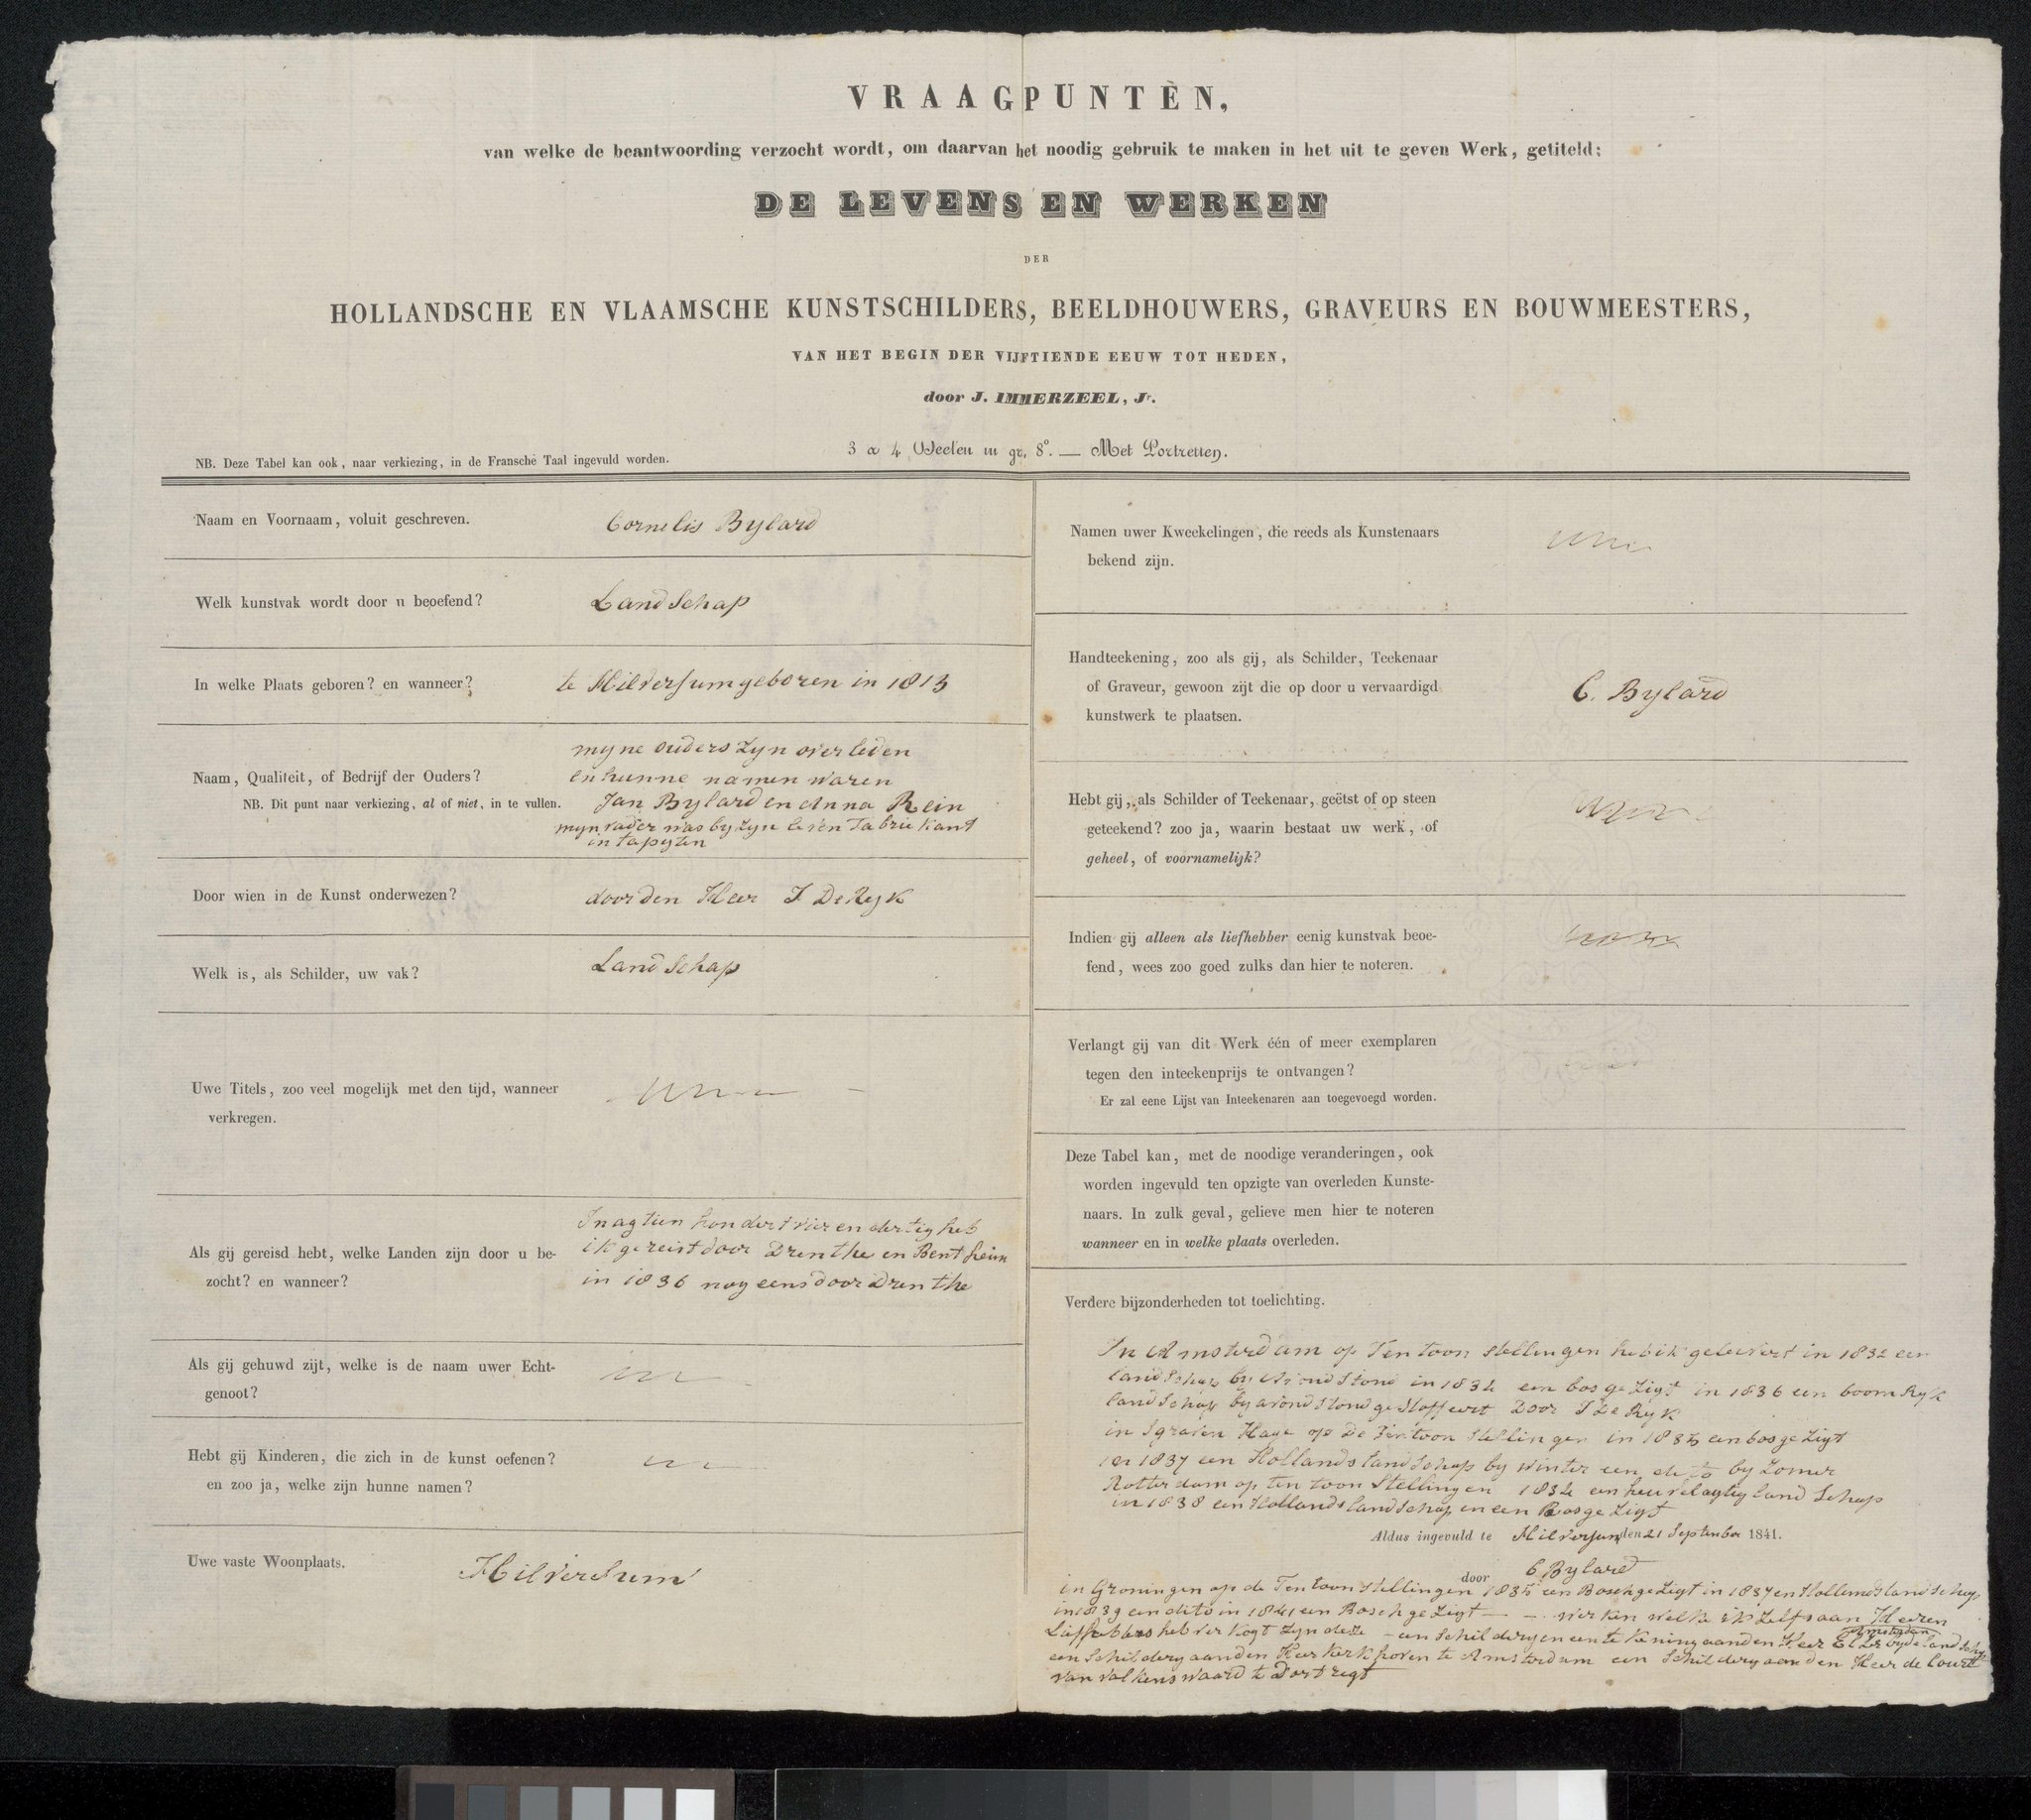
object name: manuscript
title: Enquêteformulier ingevuld door Cornelis Bijlard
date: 1841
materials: ink, paper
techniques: pen, printing, writing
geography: hilversum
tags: painter, draughtsman, cornelis bijlard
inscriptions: inscription: ‘Vraagpunten,/ van welke de beantwoording verzocht wordt, om daarvan het noodig gebruik te maken in het uit te geven Werk, getiteld: De levens en werken/ der Hollandsche en Vlaamsche kunstschilders, beeldhouwers,/ graveurs en bouwmeesters, van het begin der vijftiende eeuw tot heden/ door J. Immerzeel, Jr.’, watermark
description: Opgenomen in: Immerzeel, J. Jr., De levens en werken der Hollandsche en Vlaamsche kunstschilders, beeldhouwers, graveurs en bouwmeesters, van het begin der vijftiende eeuw tot heden, Amsterdam: J.C. van Kesteren, 1842-1843.